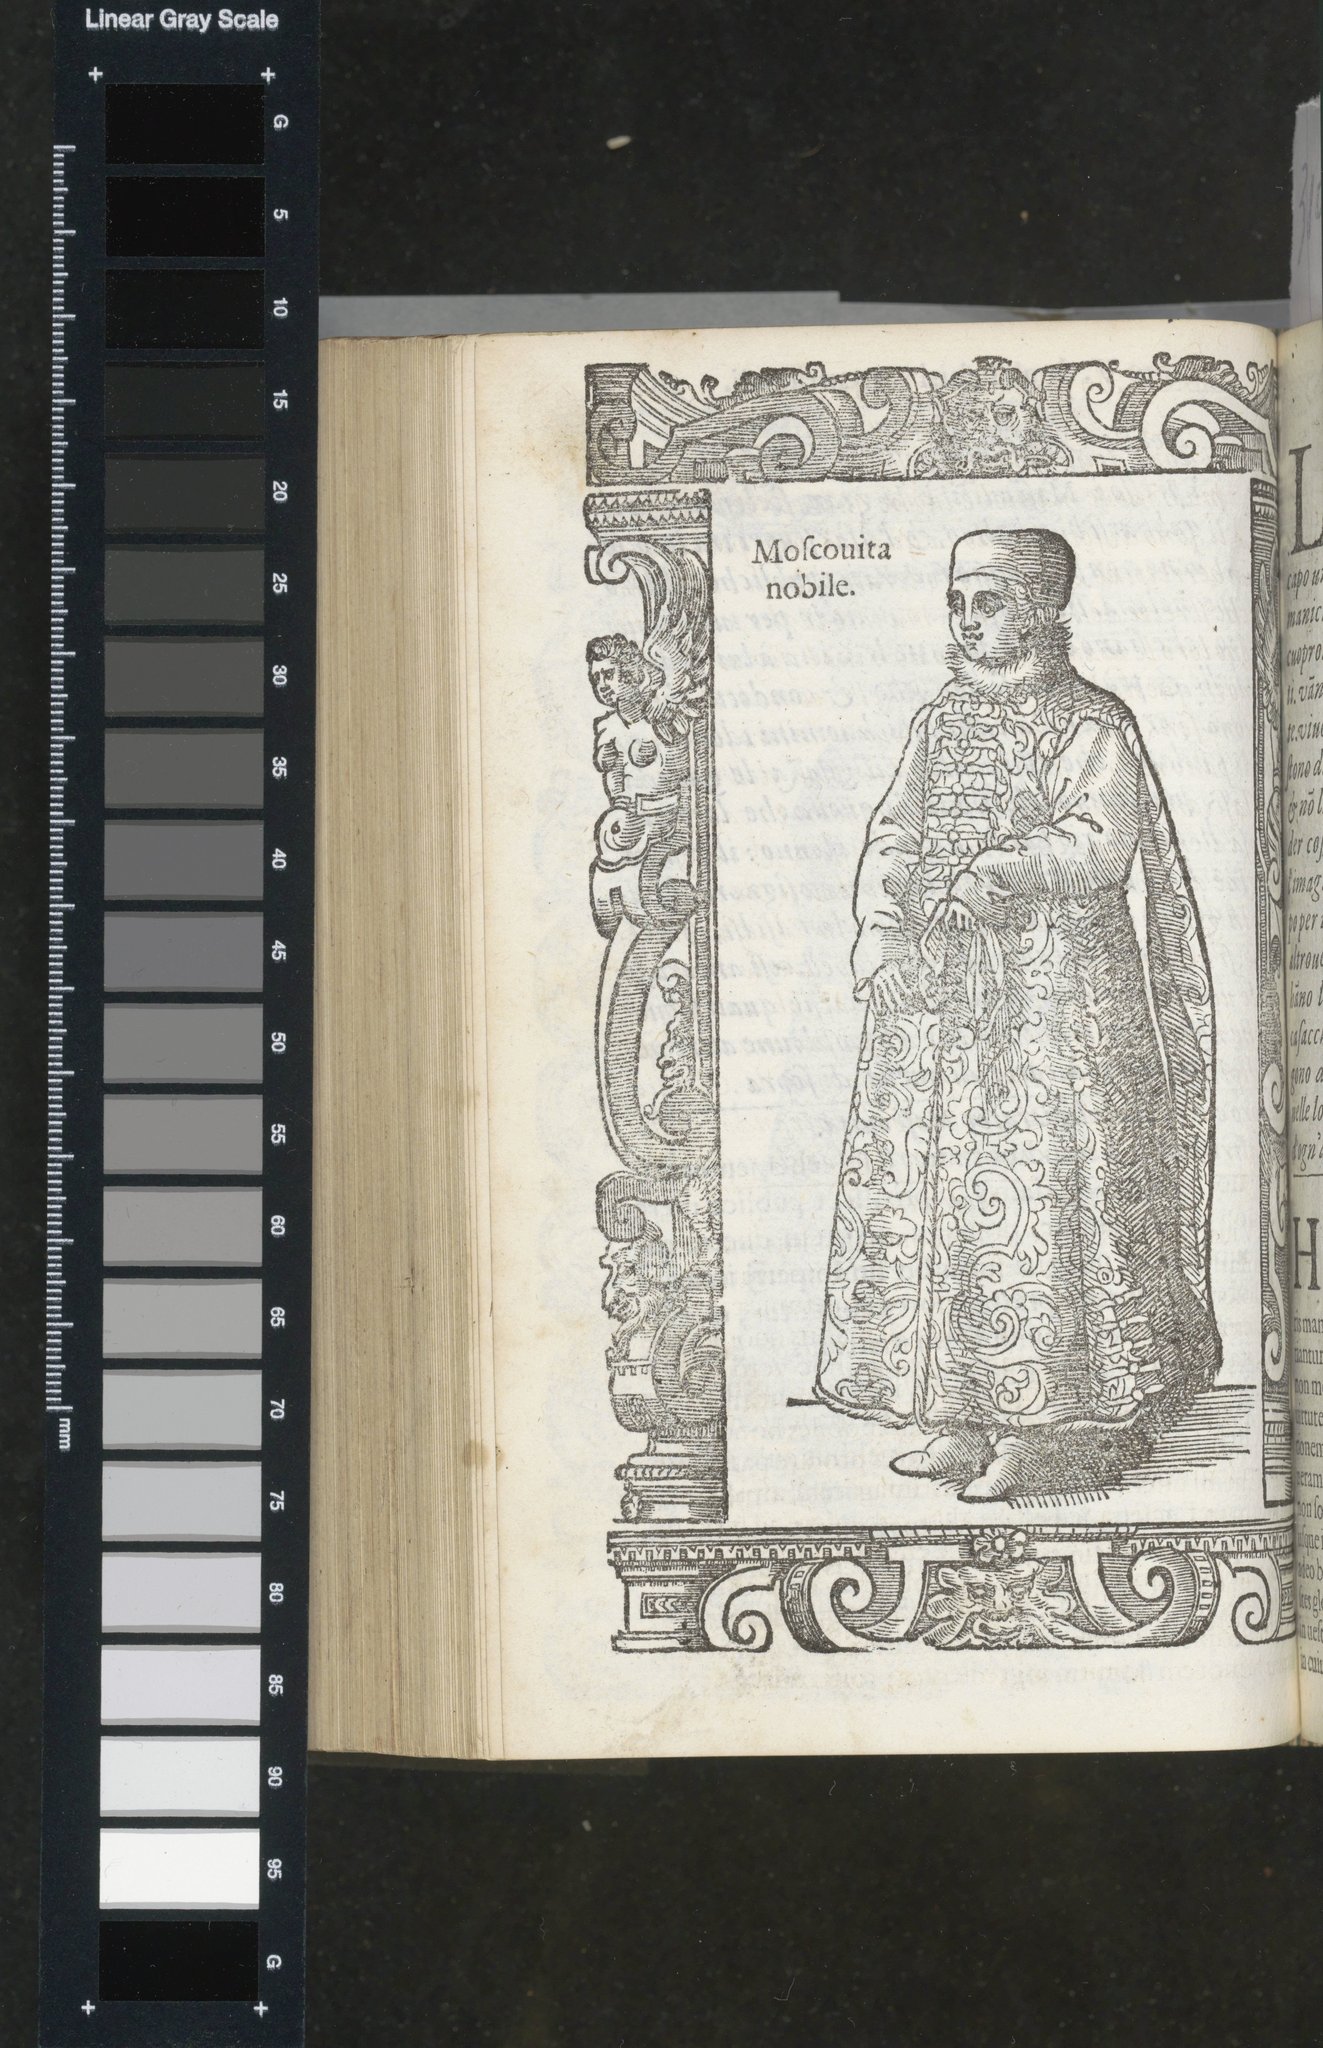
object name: costume print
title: Habiti antichi, et moderni di tutto il mondo...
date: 1598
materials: paper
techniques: woodcut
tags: fashion plates